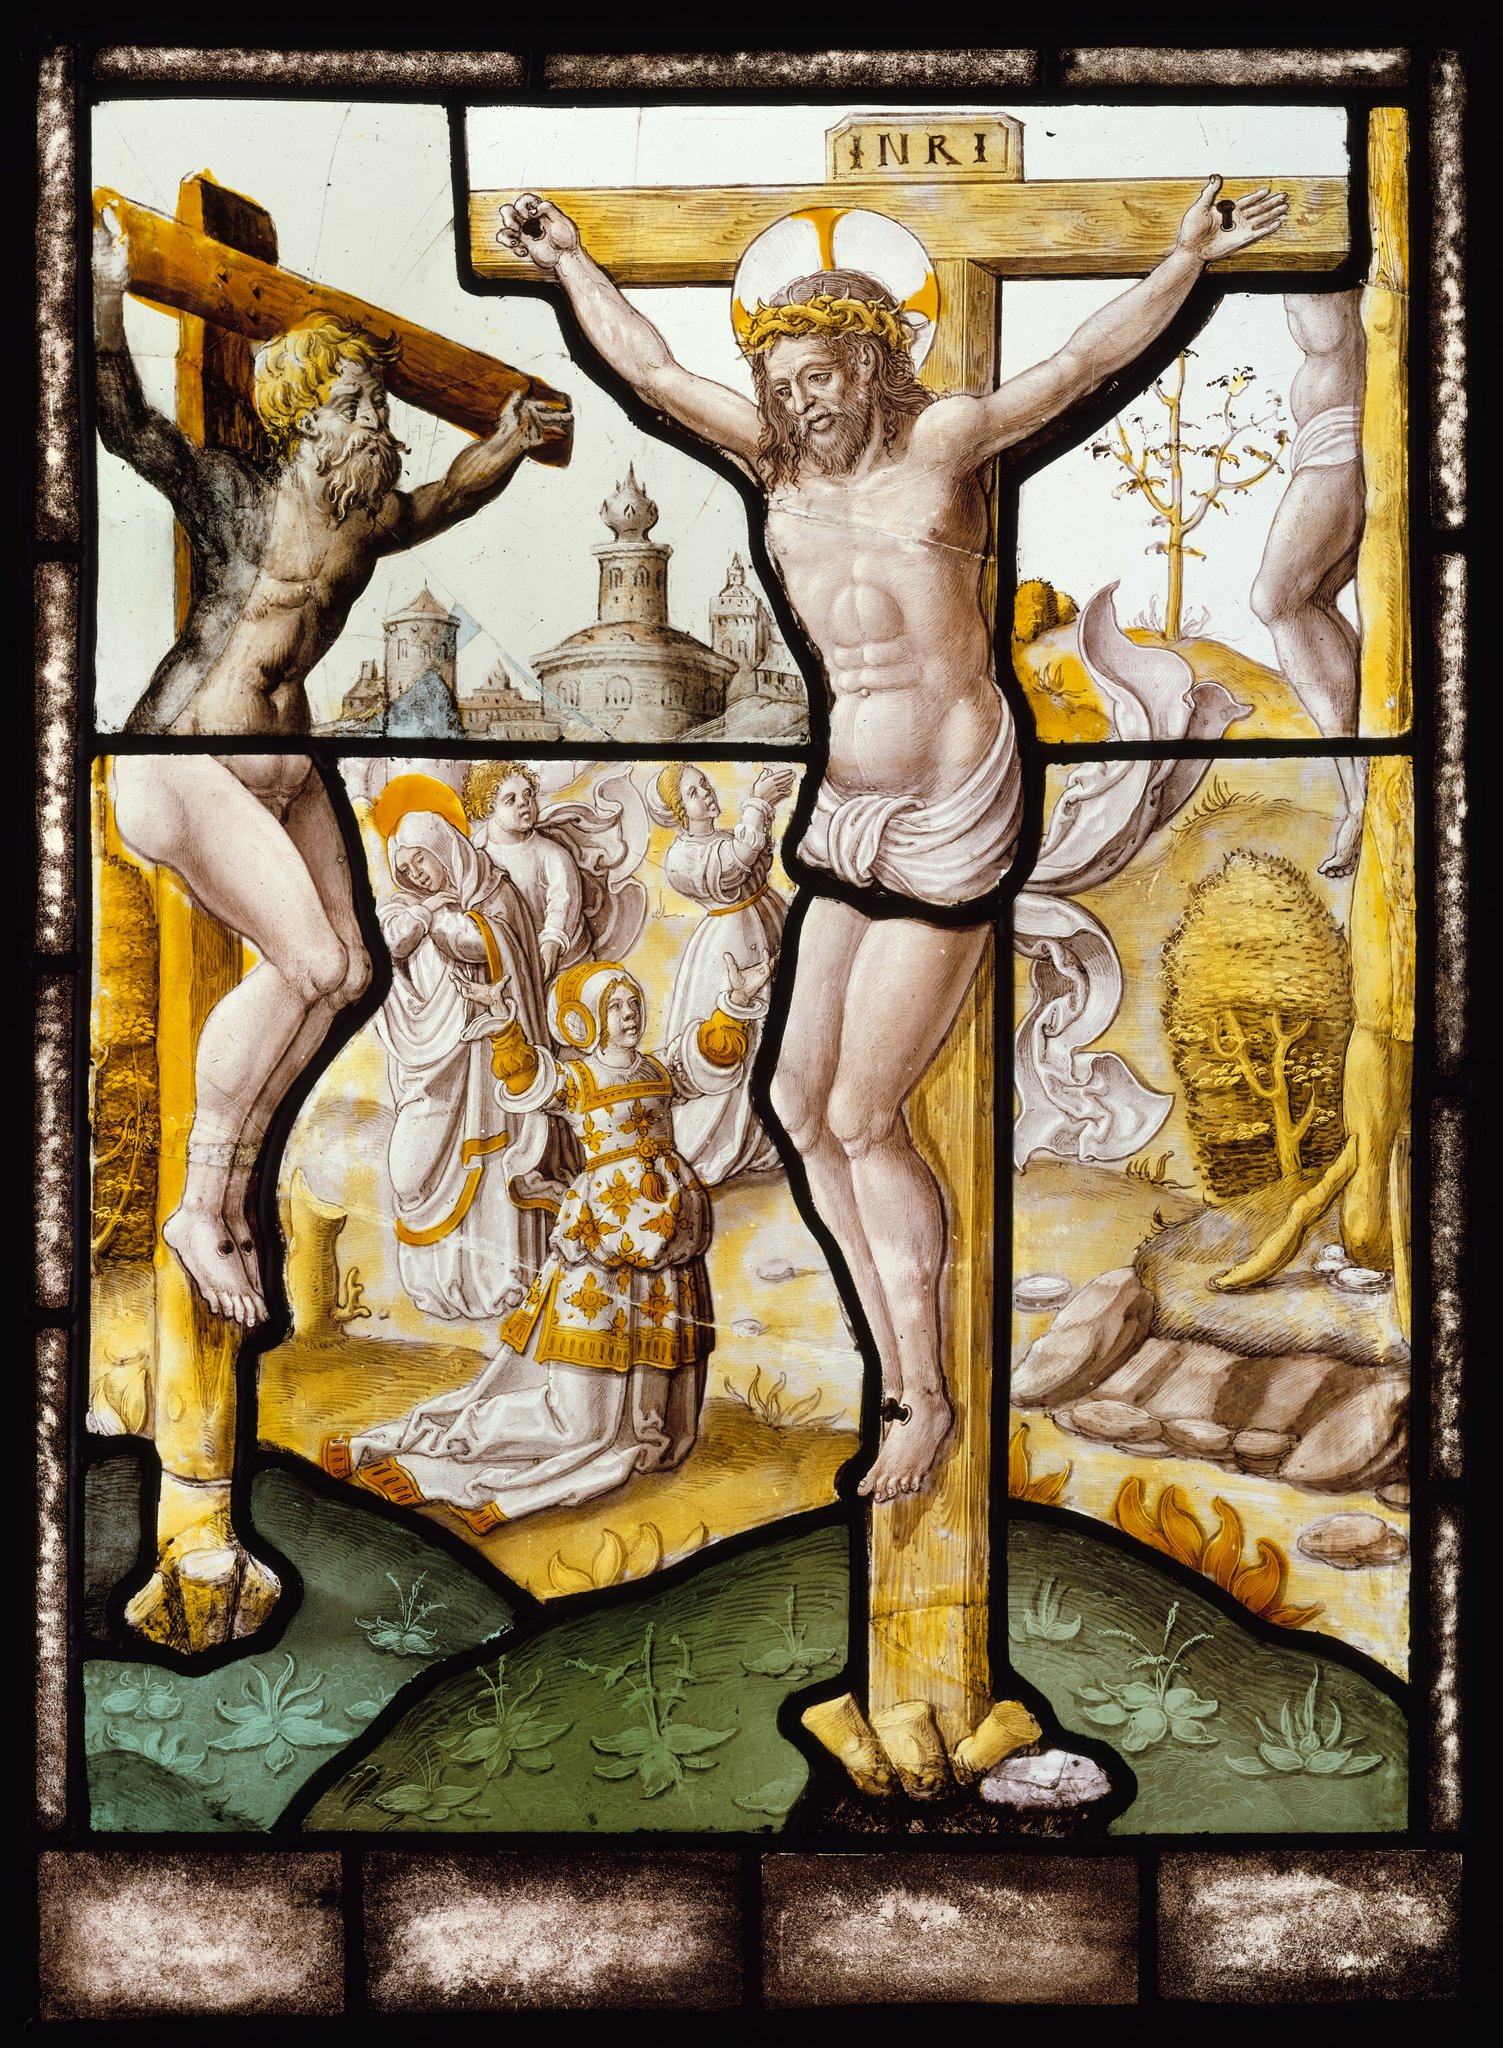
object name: panel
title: The Crucifixion (one of a set of 12 scenes from The Life of Christ)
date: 1525-1530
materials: glass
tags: sadness,women,christ,crucifixion